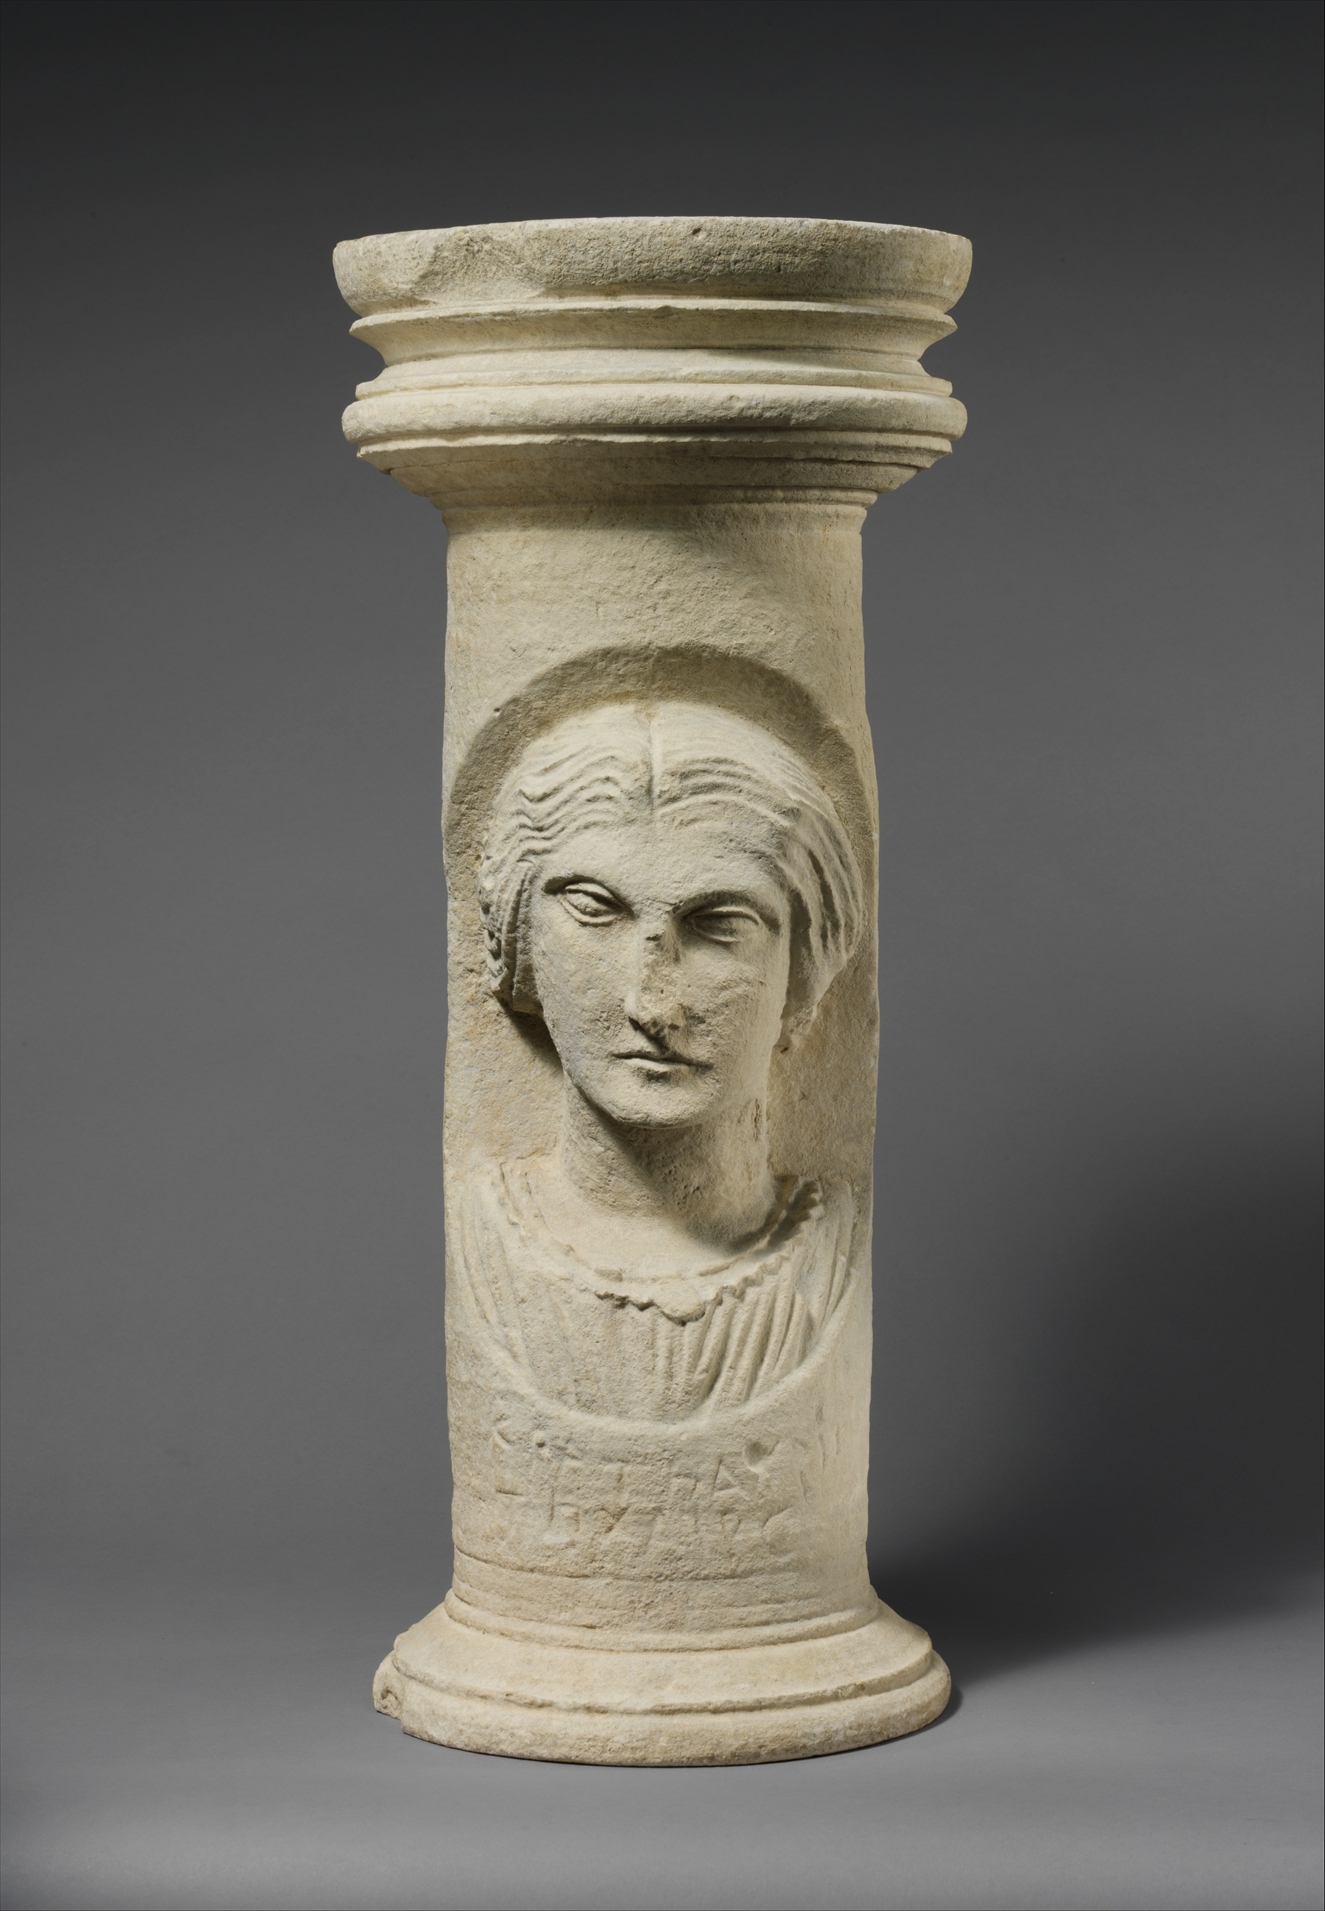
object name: cippus of kratea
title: Limestone funerary cippus (tomb marker)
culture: roman, cypriot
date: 101-300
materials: limestone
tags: portraits,women